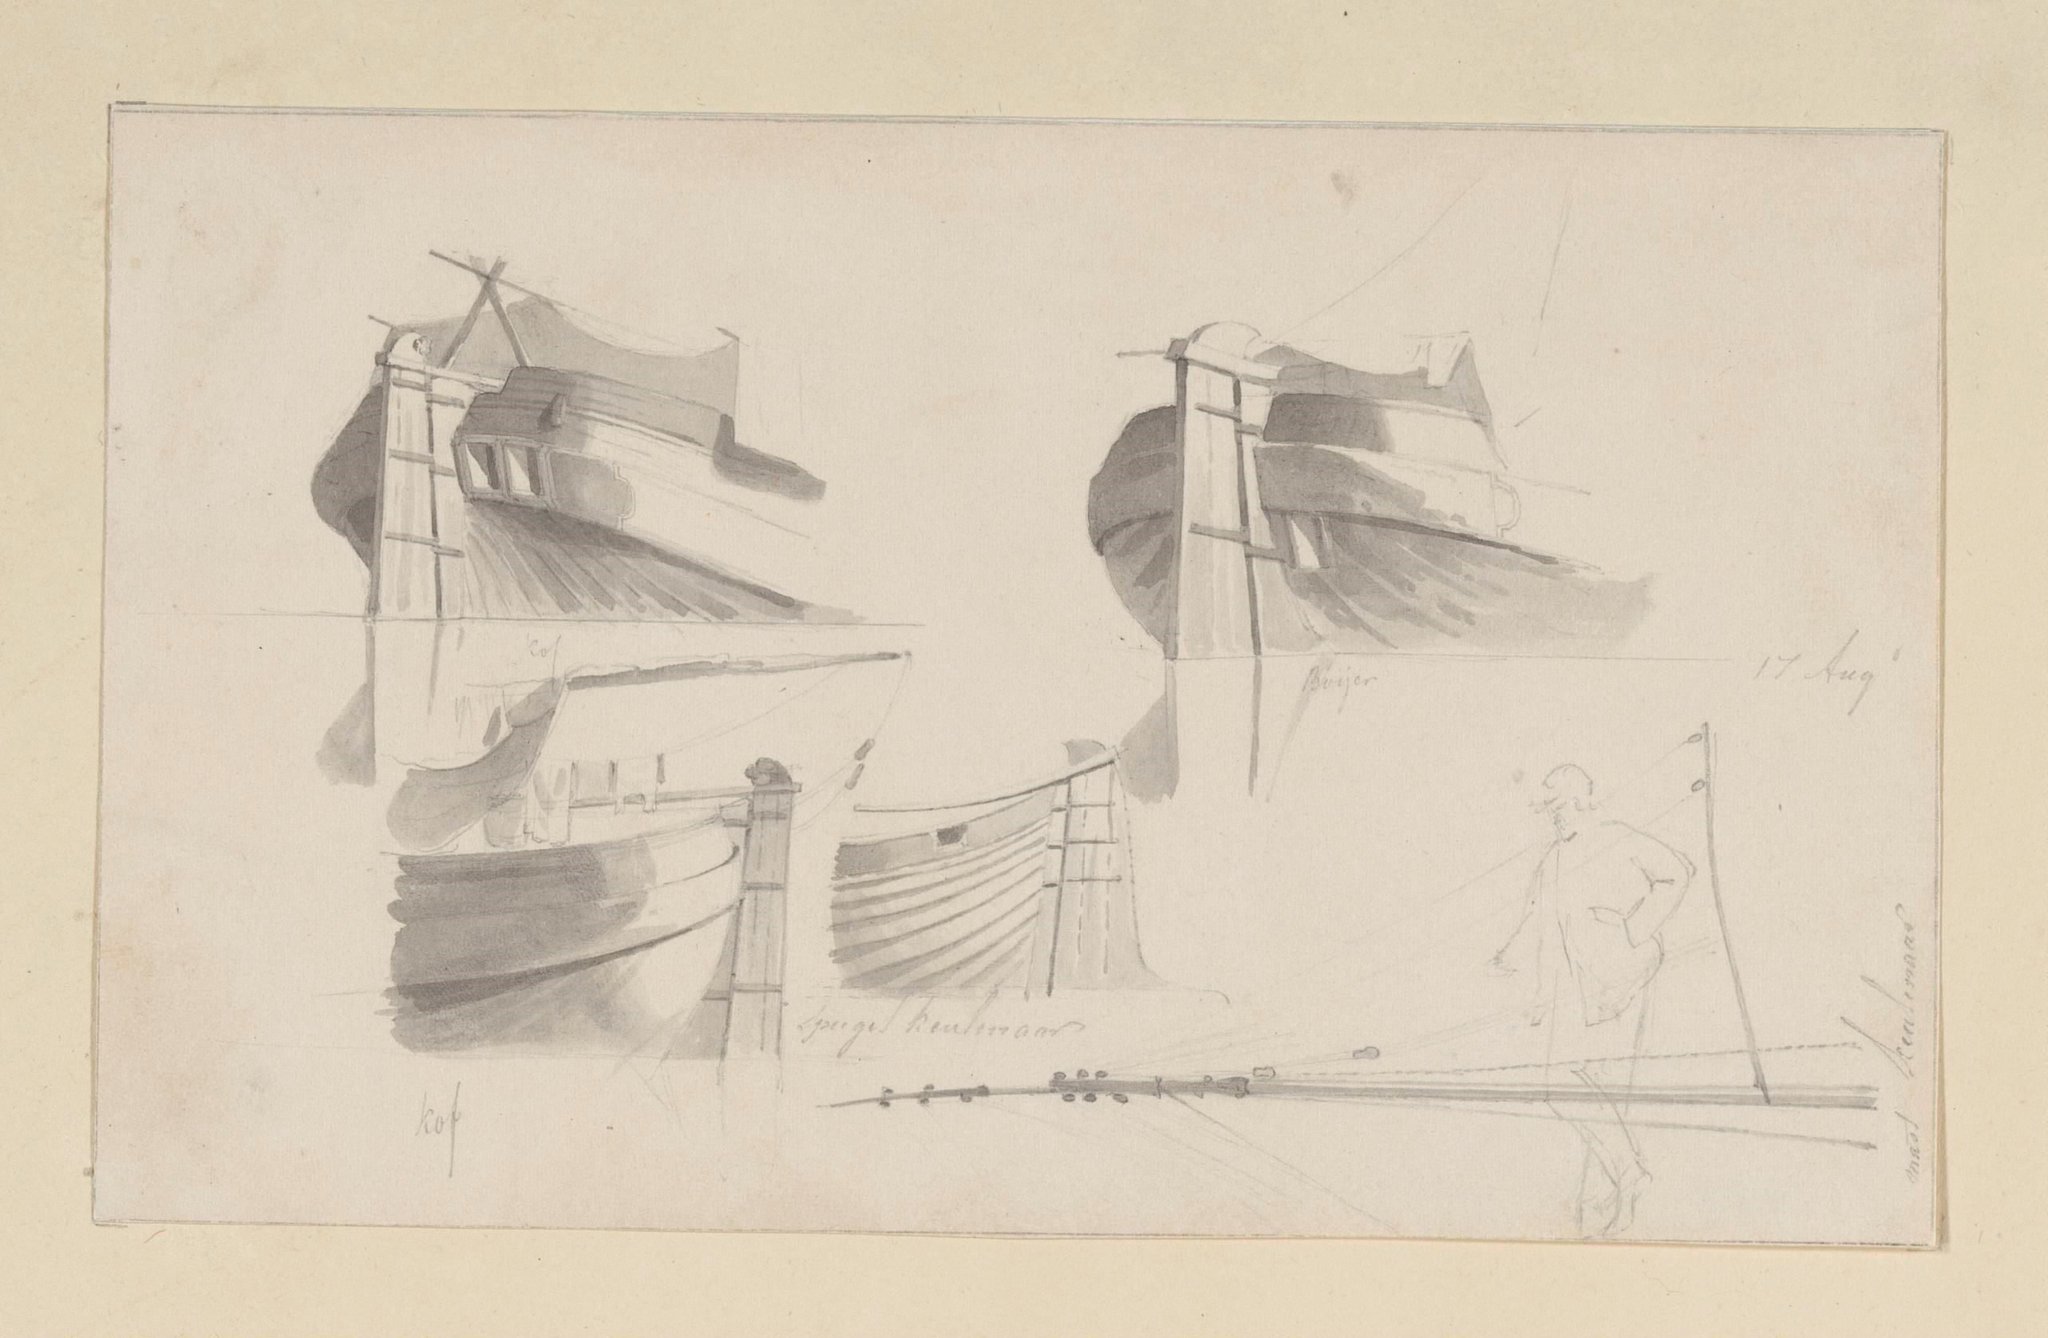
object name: drawing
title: Studieblad met roeren van zeilschepen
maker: hendrik abraham klinkhamer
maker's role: draughtsman, painter, print maker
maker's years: 1810-1872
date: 1820-1872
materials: paper, pencil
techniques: brush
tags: sailing-ship, sailing-boat (koff), sailing-ship, sailing-boat (boyer), parts of ship's exterior: rudder